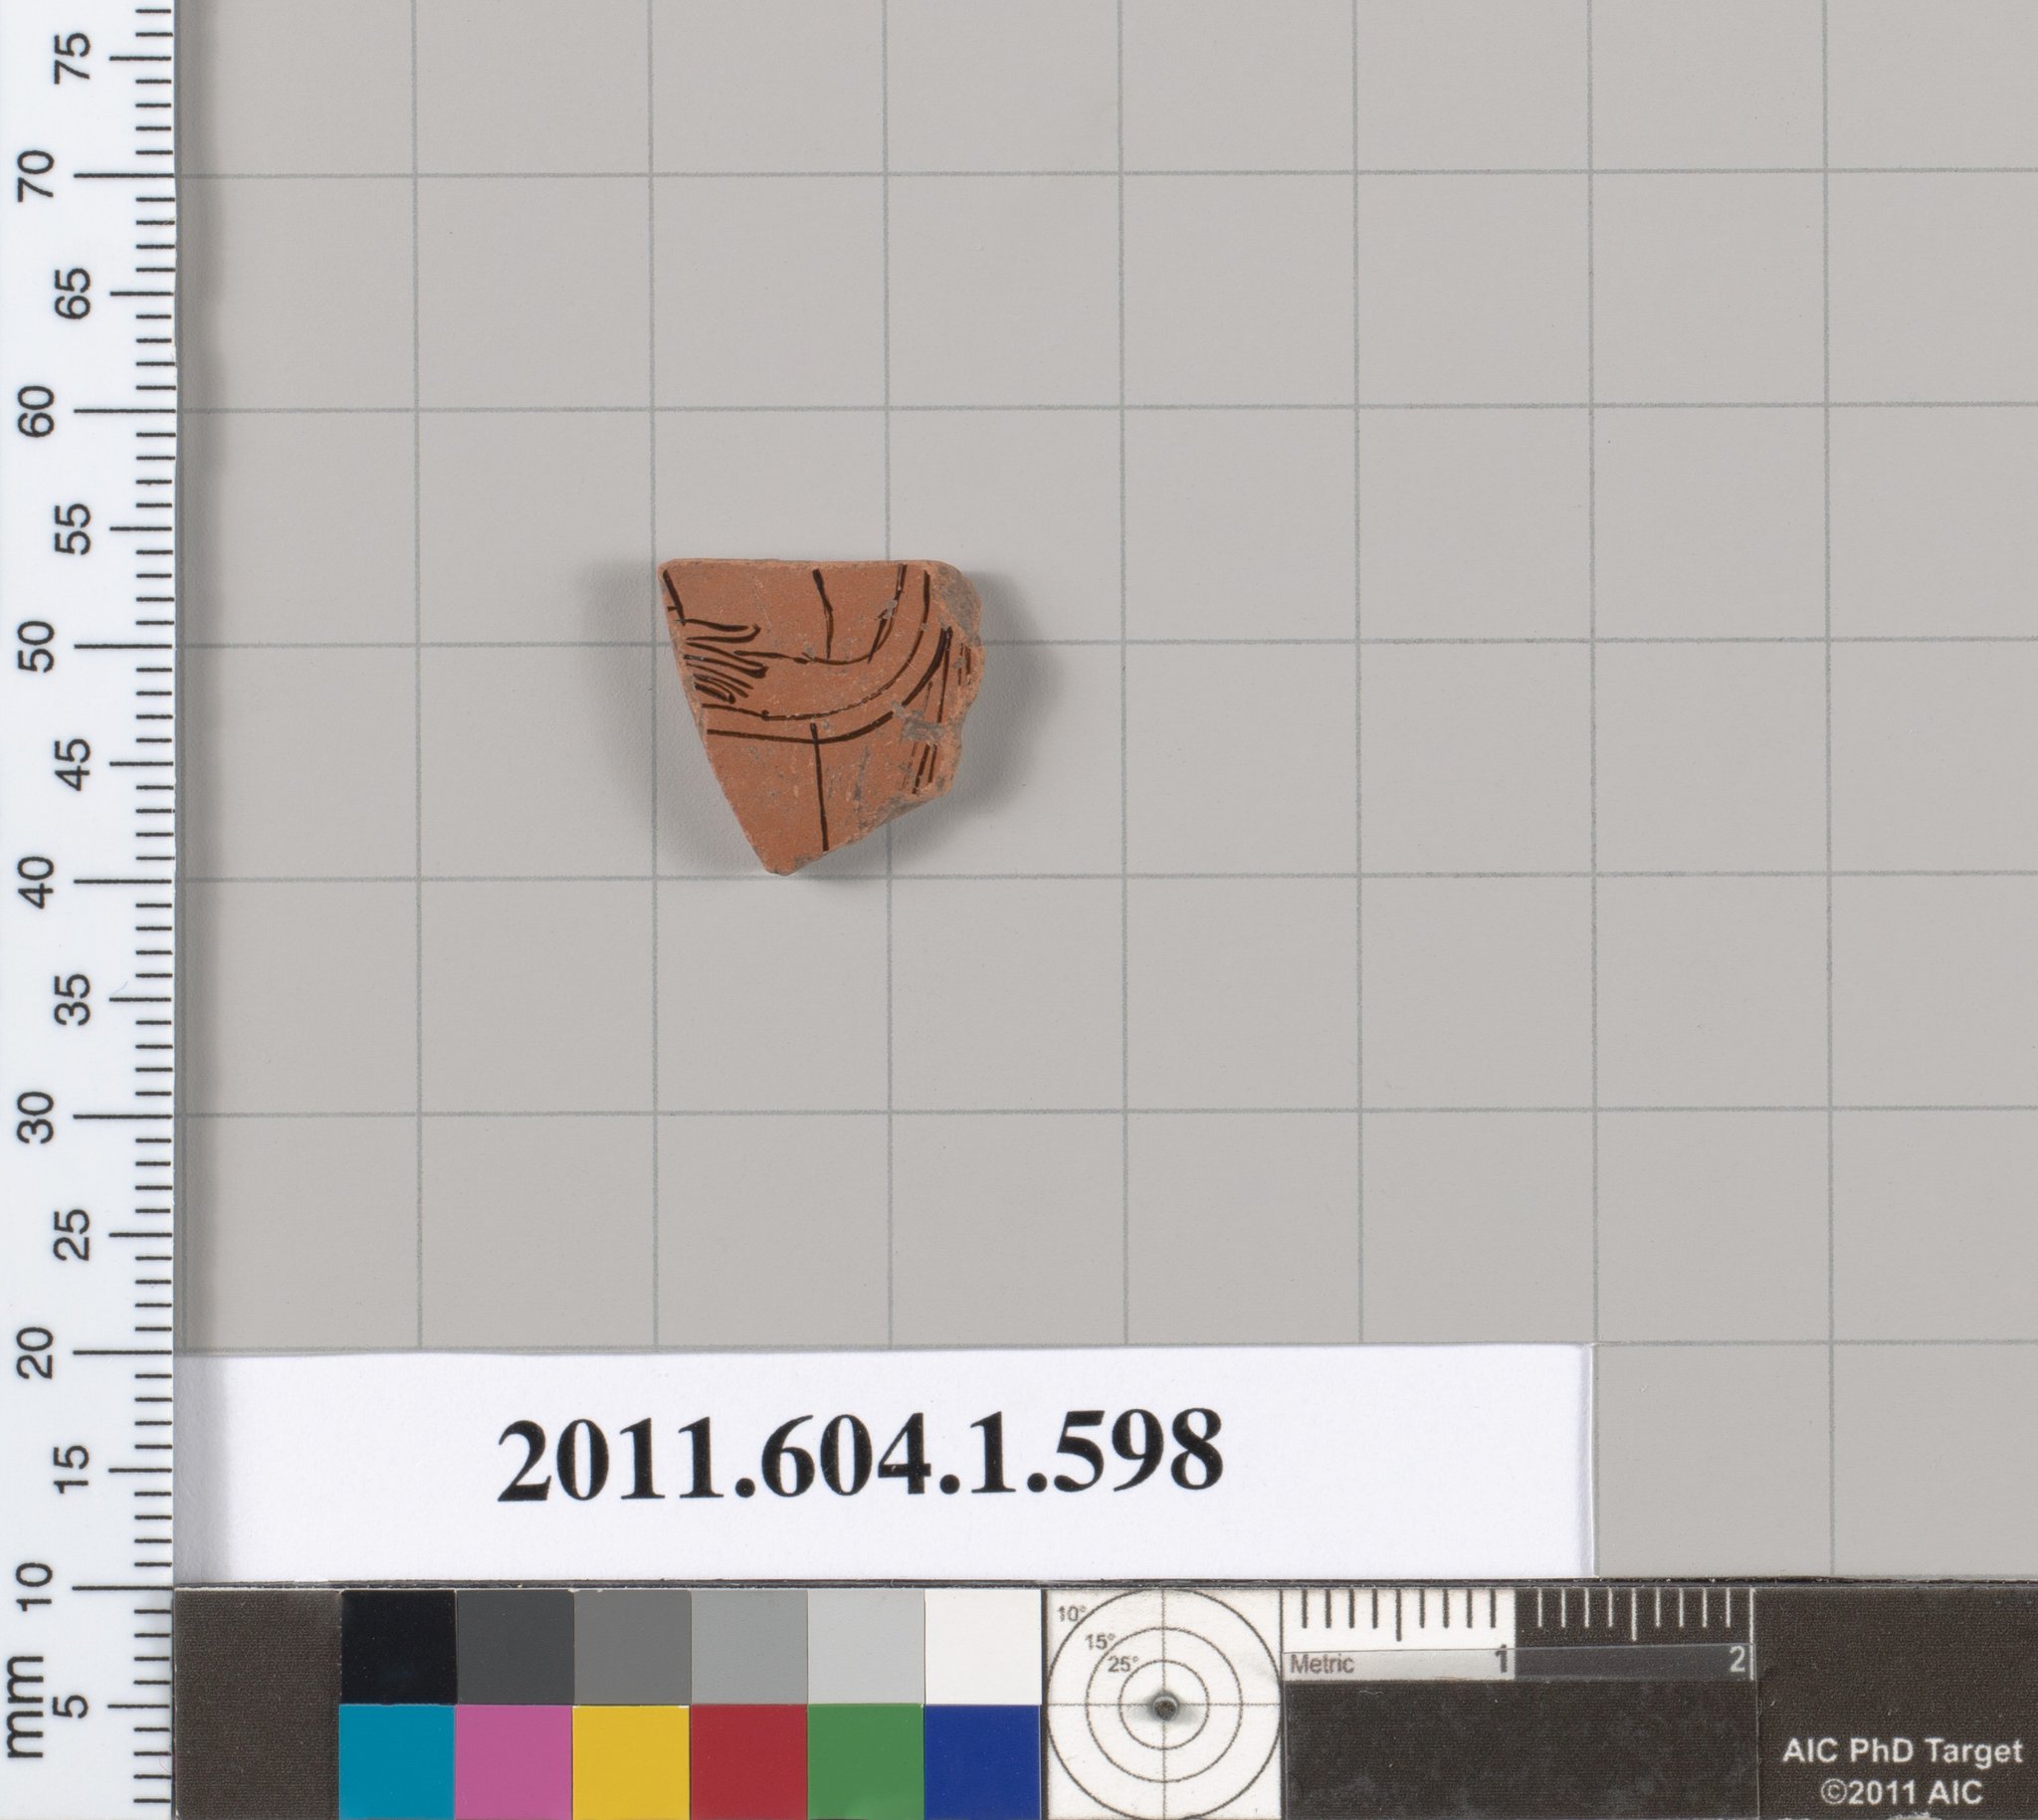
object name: kylix fragment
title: Terracotta fragment of a kylix (drinking cup)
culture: greek, attic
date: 475-451 BCE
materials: terracotta